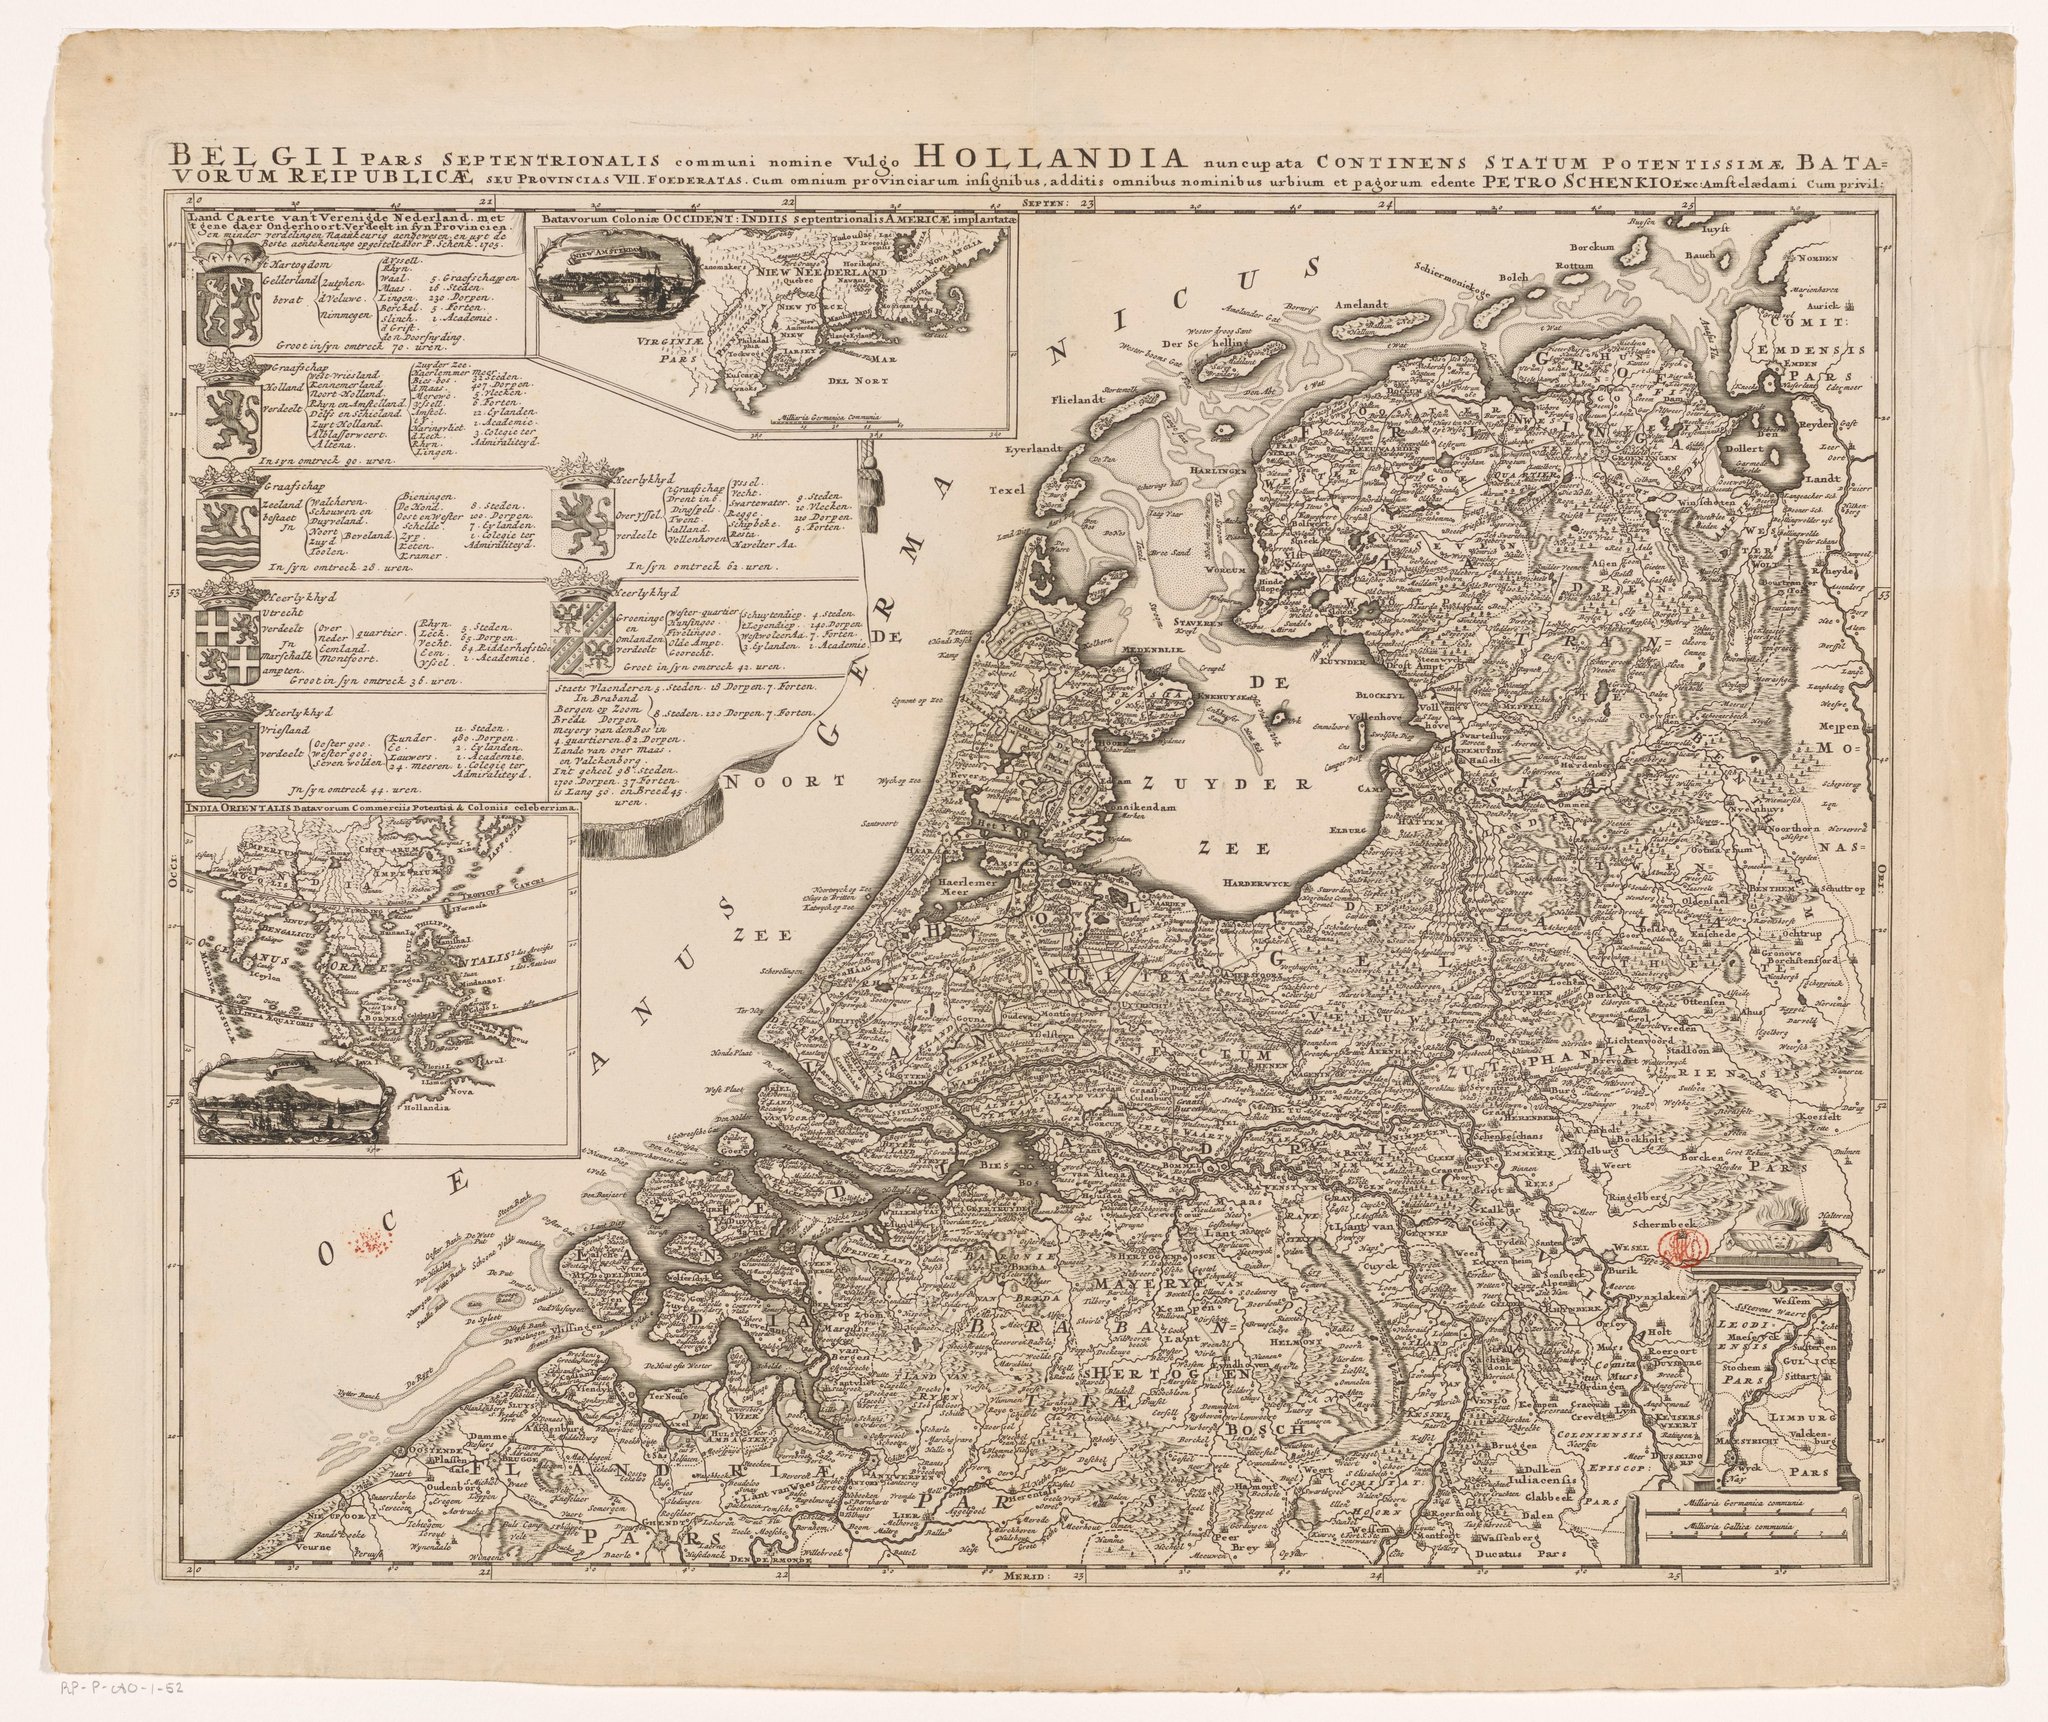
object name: print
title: Land caerte van 't Verenigde Nederland met 't gene daer onderhoort verdeelt in syn provincien / Belgii pars septentrionalis communi nomine vulgo Hollandia (...)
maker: pieter schenk (i)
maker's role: print maker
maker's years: 1660-1711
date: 1705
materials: paper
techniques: engraving, etching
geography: amsterdam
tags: coat of arms (as symbol of the state, etc.), maps of separate countries or regions, netherlands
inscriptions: collector's mark: Lugt 2228, collector's mark: Lugt 195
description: Linksboven een cartouche met de wapens van en topografische en staatkundige informatie over de Zeven Provinciën. Rechts daarvan een inzetkaart van Nieuw Nederland en een ovaal stadsgezicht van Nieuw Amsterdam, bijhorende schaalstok: Milliaria Germanica communia. Onder de eerstgenoemde cartouche een inzetkaart van Oost-Indië en een ovaal stadsgezicht van Batavia. Rechtsonder een inzetkaart van een deel van het huidige Limburg (deel dat destijds tot Staats-Brabant behoorde). Daaronder schaalstok: Milliaria Germanica communia, Milliaria Gallica communia. Gradenverdeling langs de randen.